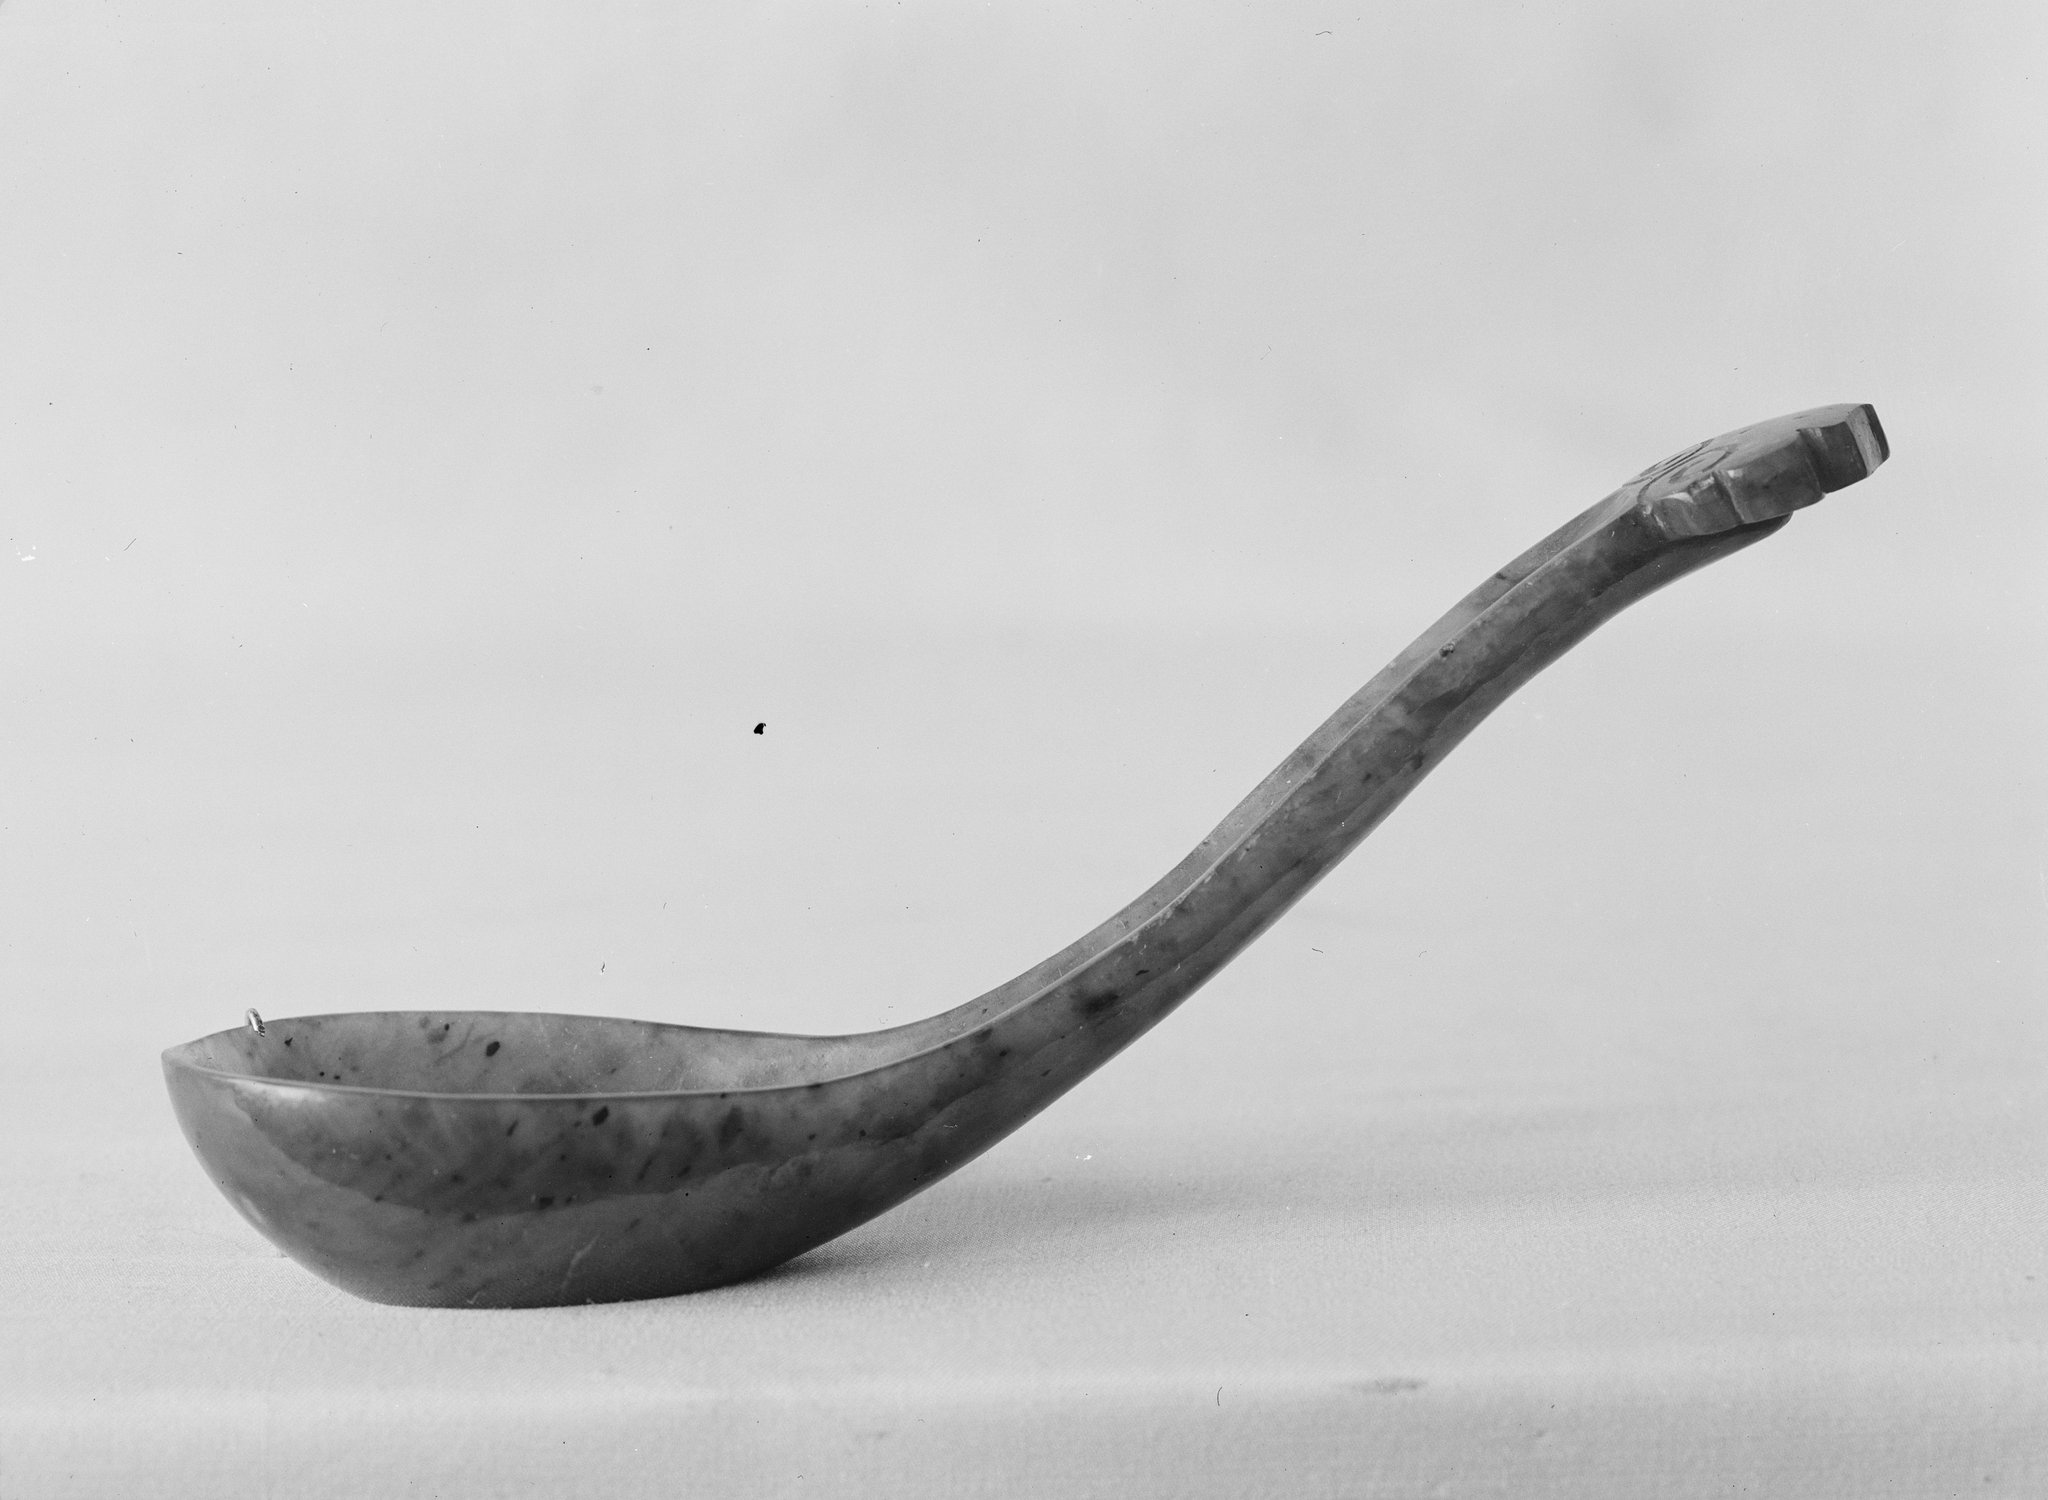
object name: spoon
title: Spoons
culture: chinese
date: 1368-1644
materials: jade